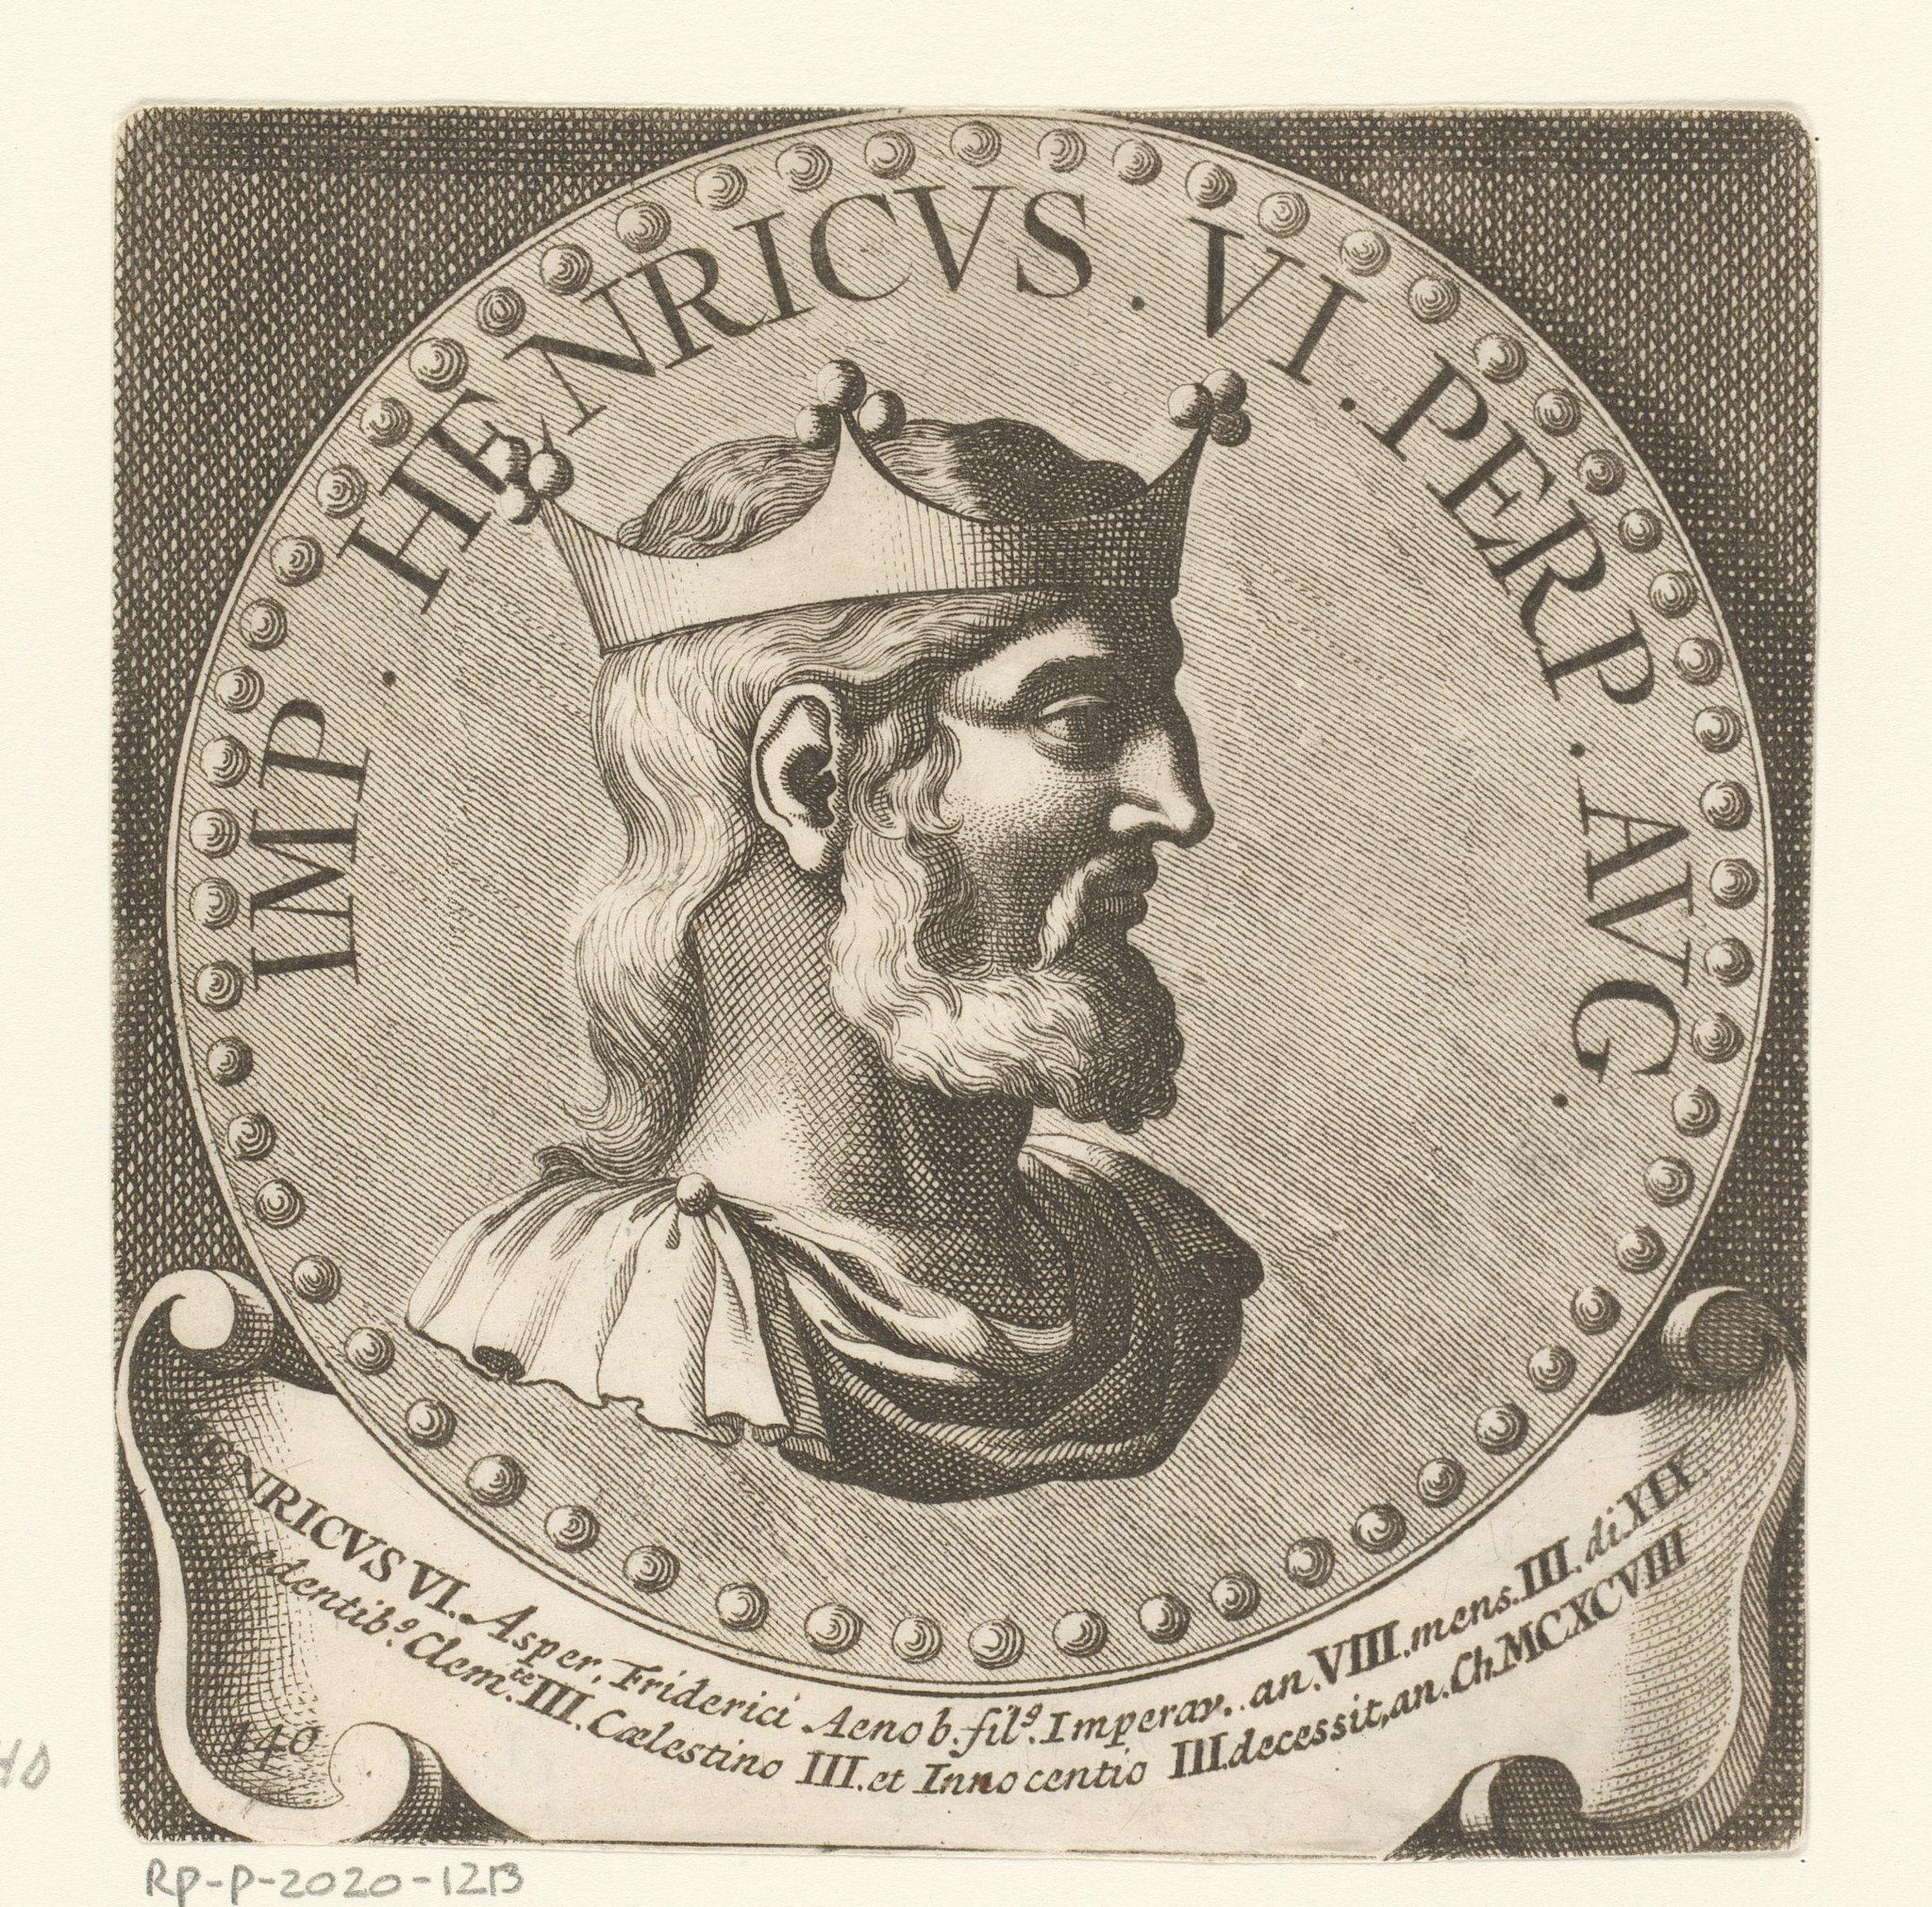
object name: book illustration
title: Imp. Henricus. VI. perp. Aug.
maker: jan van vianen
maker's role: print maker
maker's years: 1660-1726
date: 1697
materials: paper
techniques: engraving, etching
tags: nijmegen, crown (symbol of sovereignty), historical persons, emperor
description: Prent gebruikt in: Bogaert, Abraham. De Roomsche monarchy, vertoont in de muntbeelden der westersche en oostersche keizeren (...). Utrecht: François Halma en Willem van de Water, 1697, p. 387. Eerste staat verschenen als grotere prent met 12 portretten, gedateerd 1695.